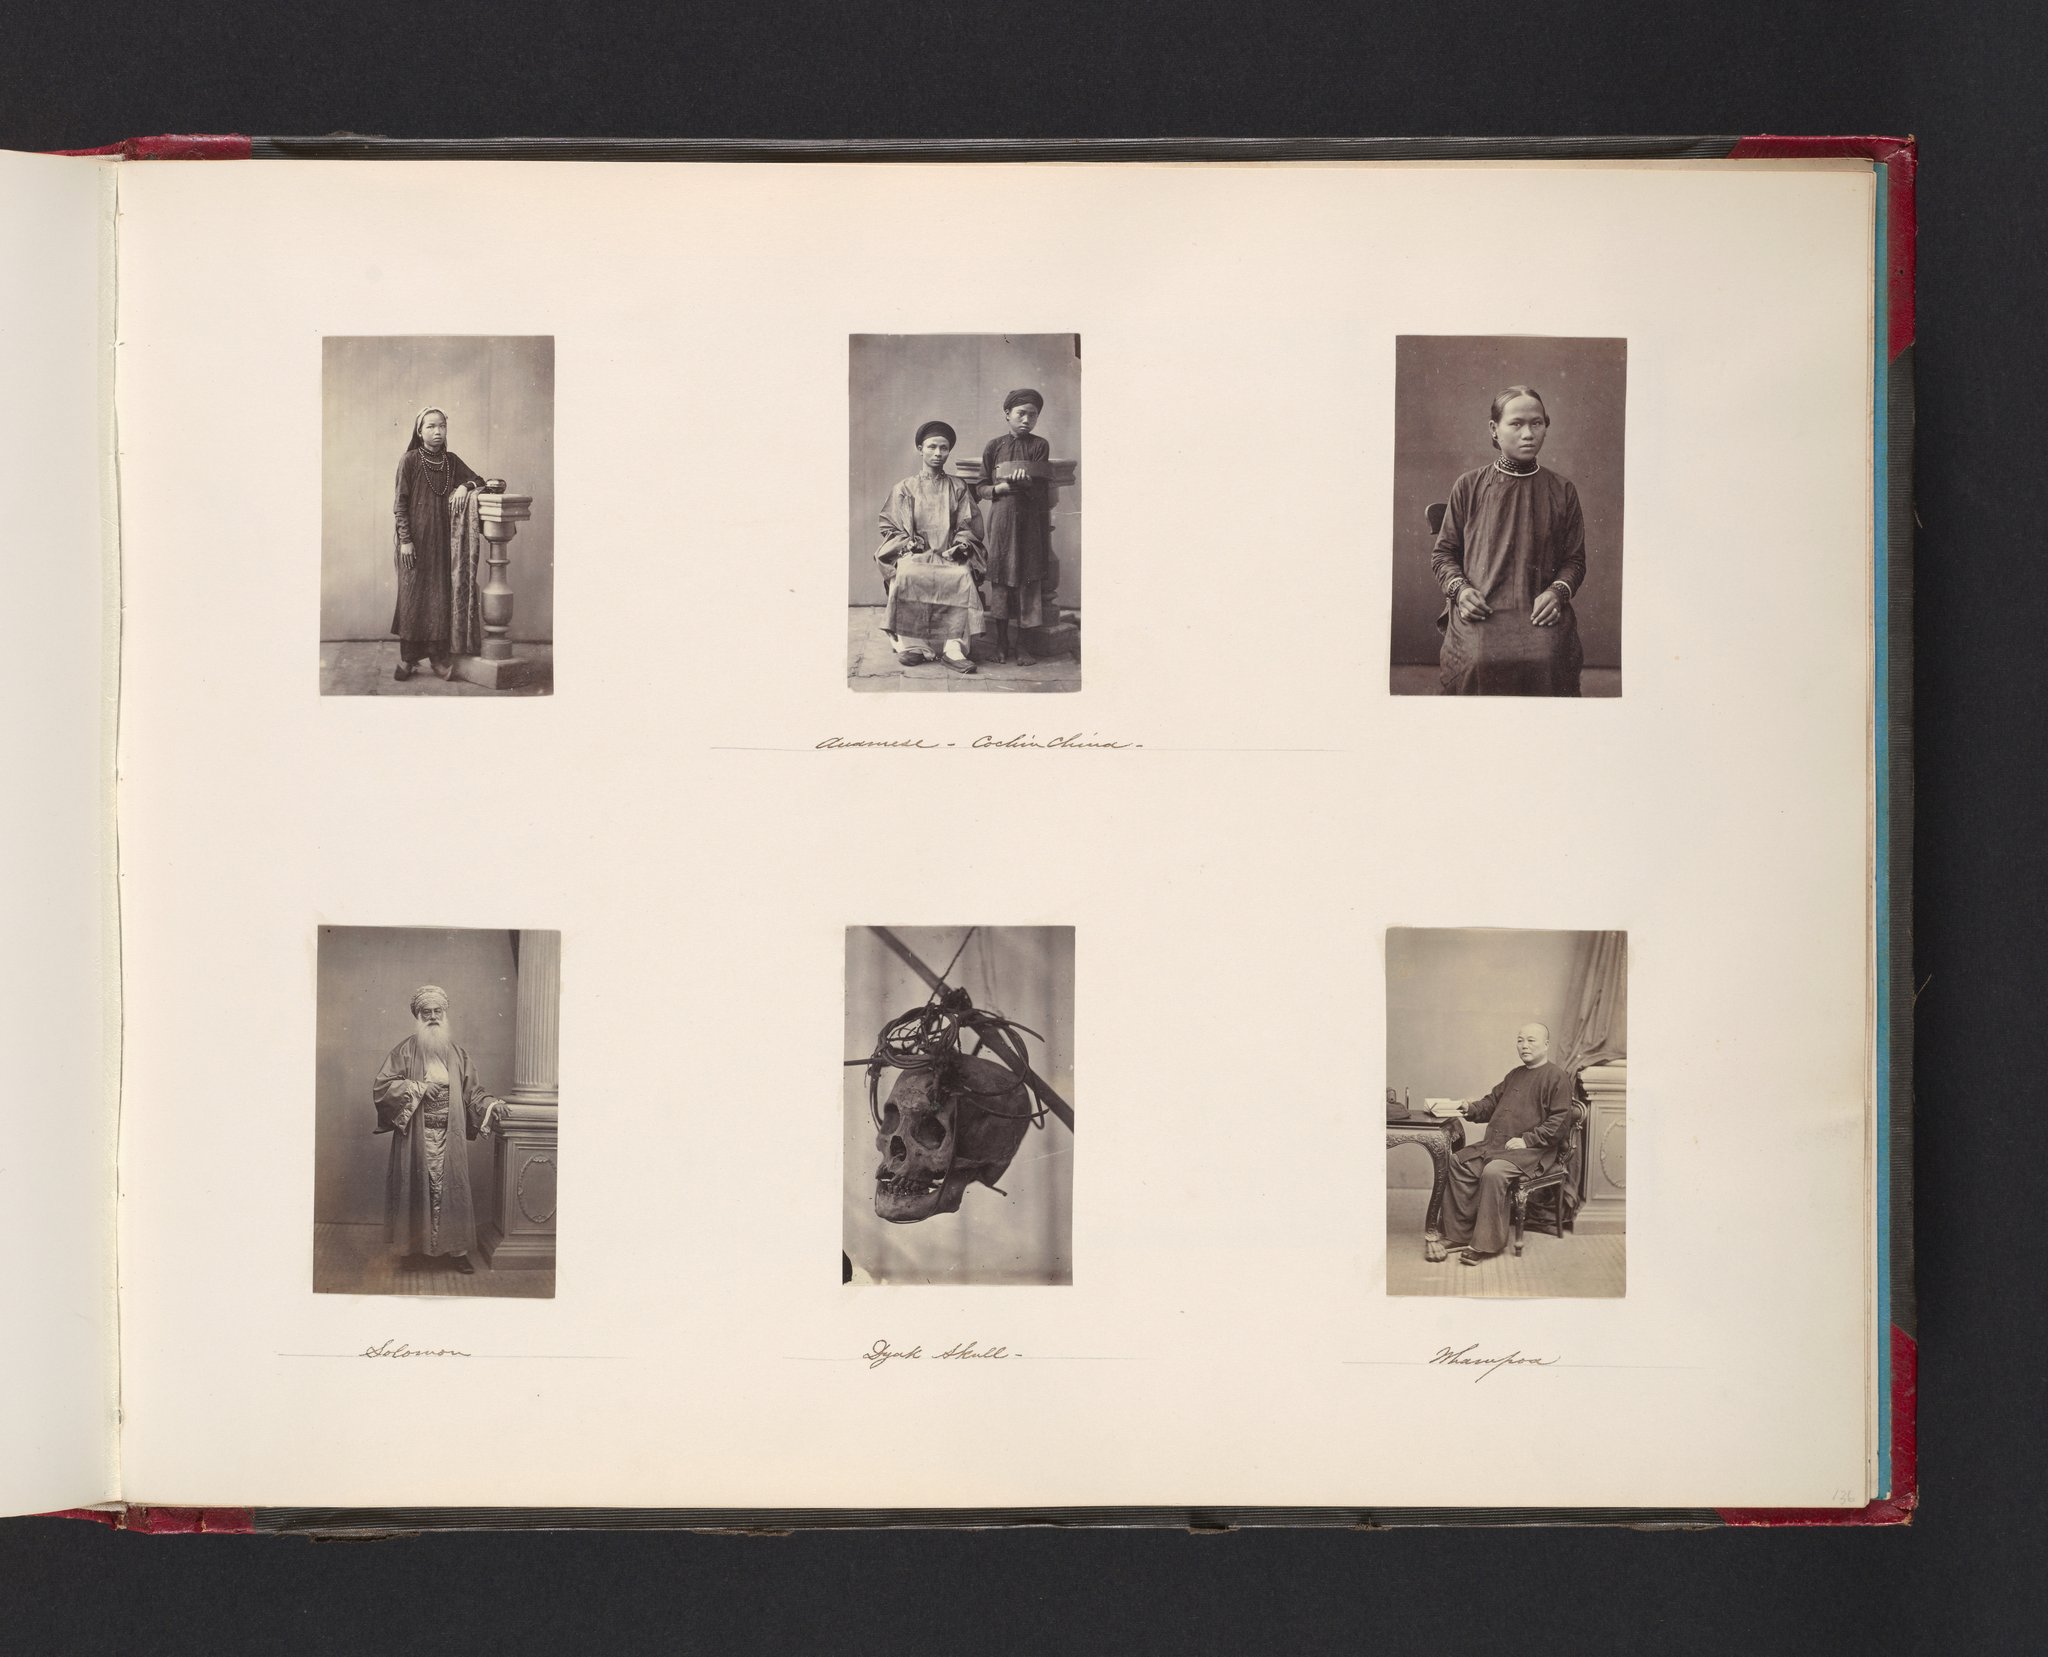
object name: photograph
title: Anamese, Cochinchina; Solomon; Dyak Skull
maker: john thomson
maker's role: artist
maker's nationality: british, scottish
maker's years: 1837-1921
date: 1865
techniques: albumen silver print, glass negative